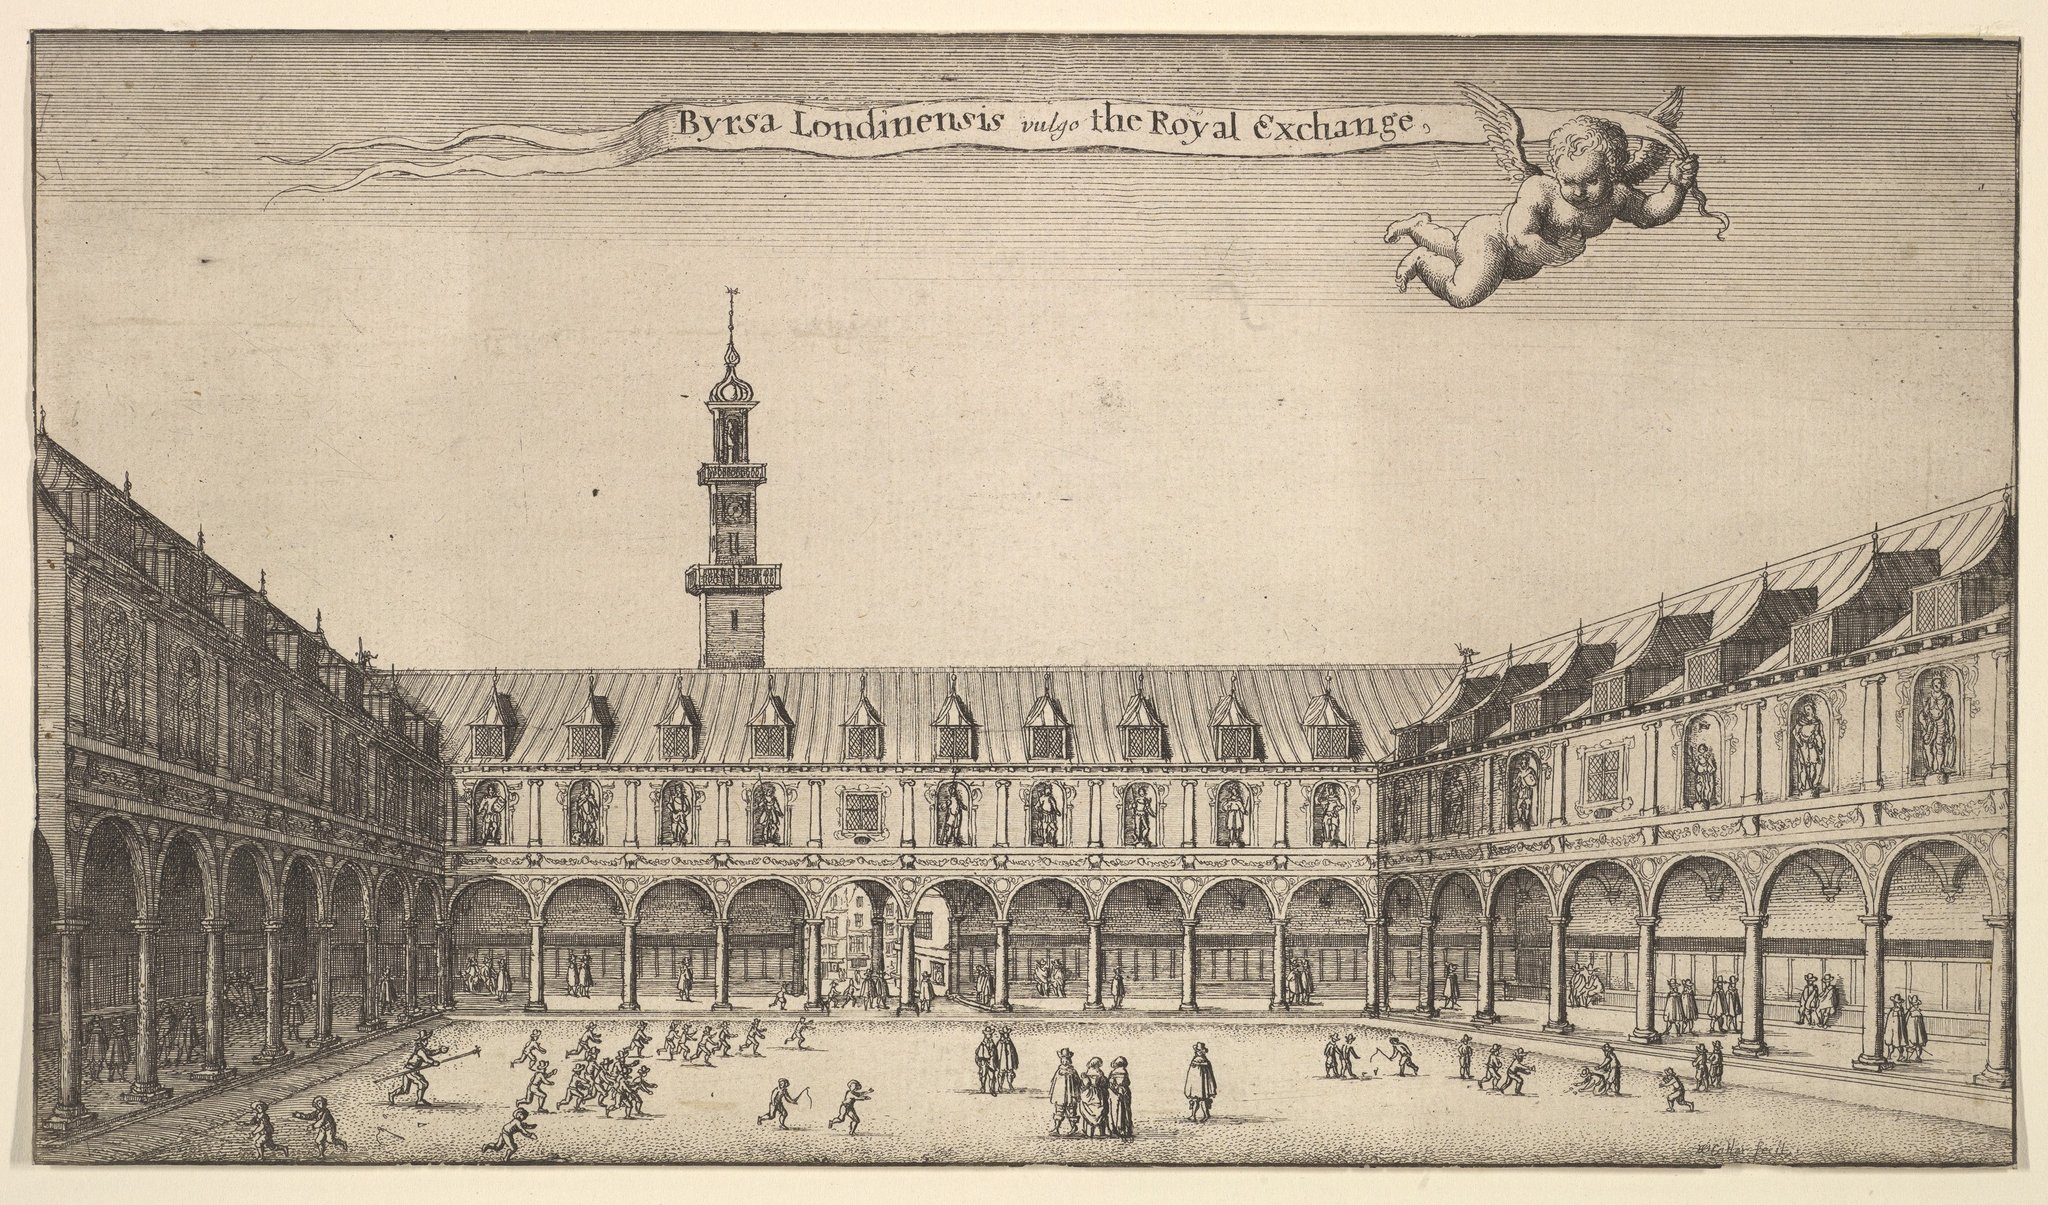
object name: print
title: Byrsa Londinensis vulgo the Royal Exchange (Royal Exchange, London)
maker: wenceslaus hollar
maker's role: artist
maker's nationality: bohemian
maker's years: 1607-1677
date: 1645-1647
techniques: etching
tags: architecture,buildings,london